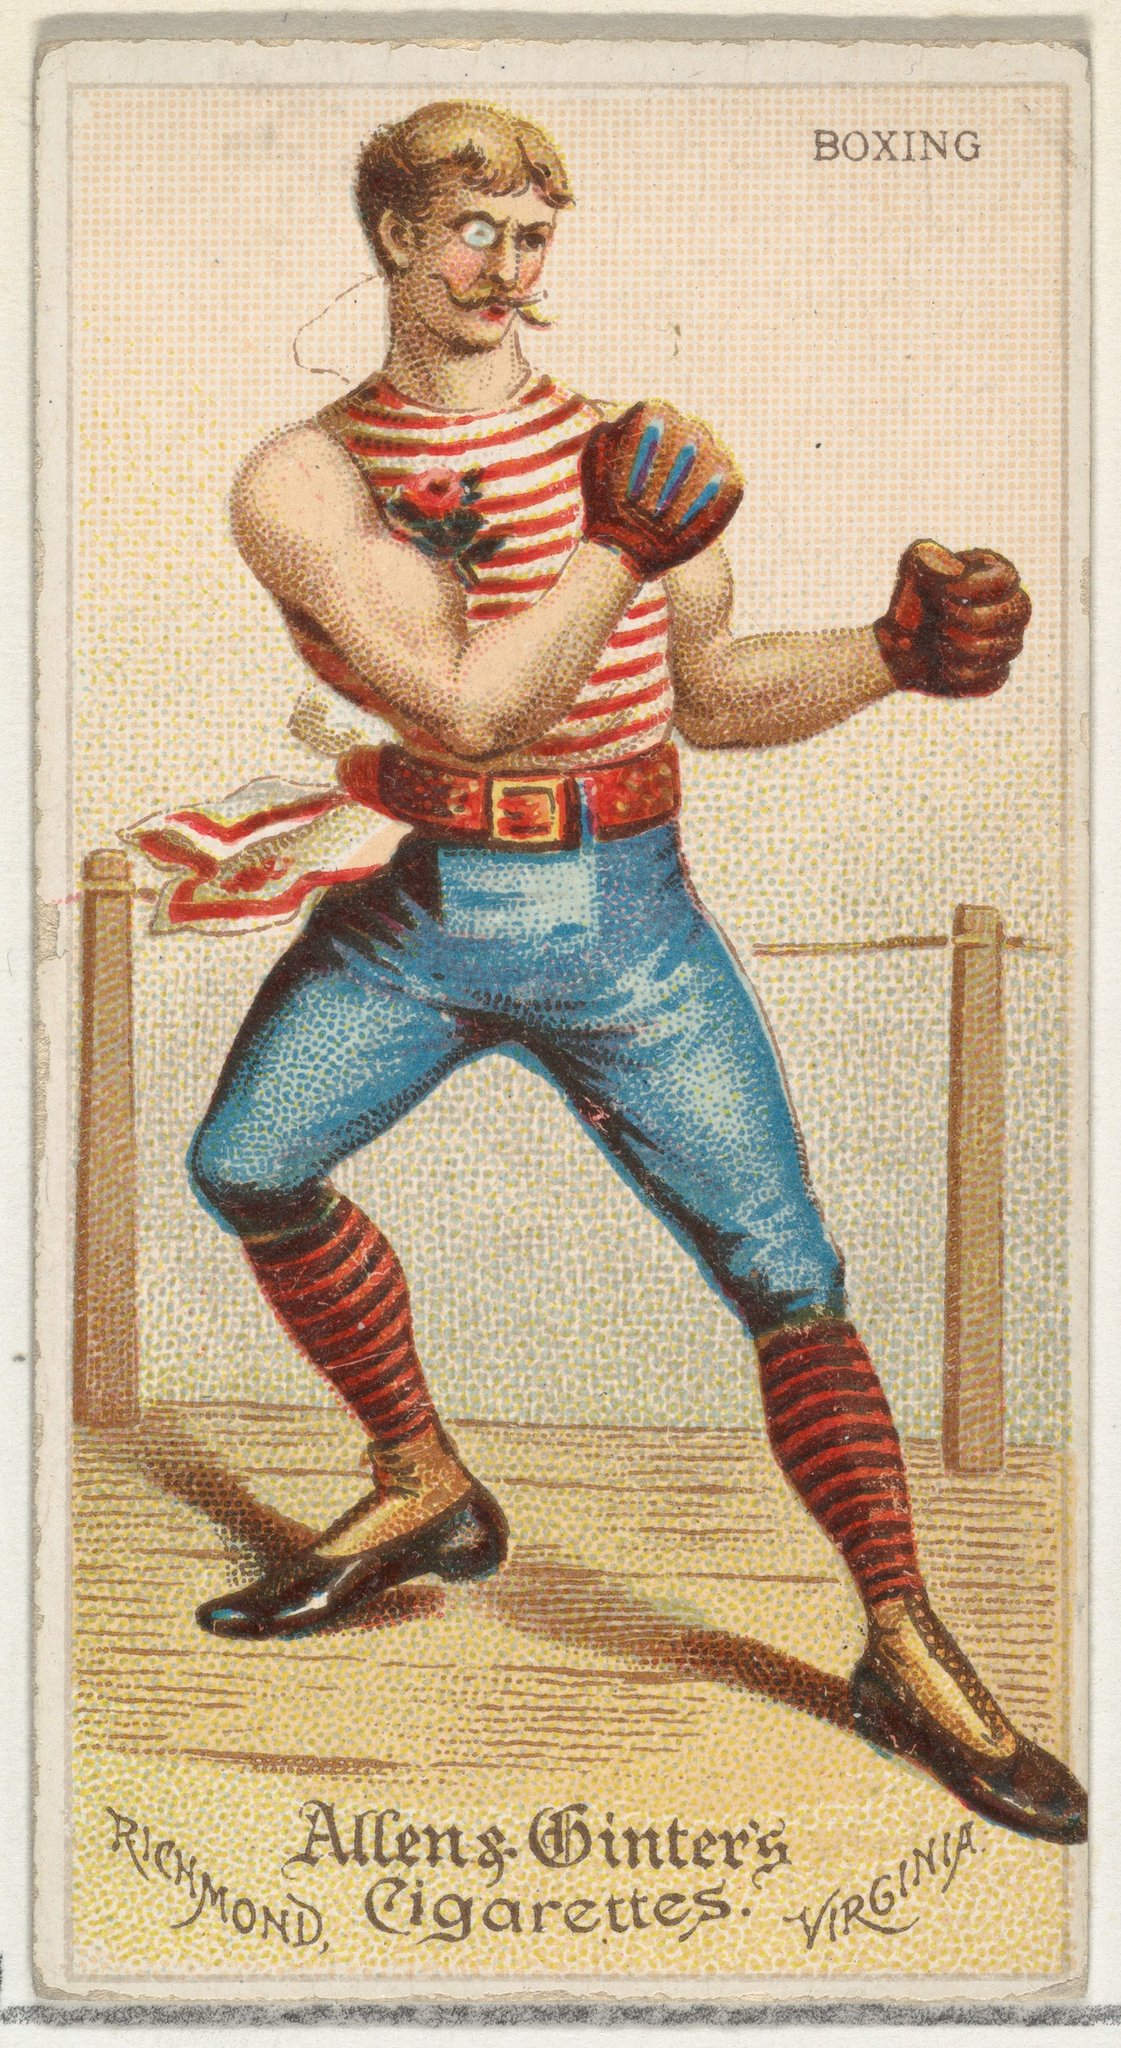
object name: print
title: Boxing, from World's Dudes series (N31) for Allen & Ginter Cigarettes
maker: allen & ginter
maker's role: publisher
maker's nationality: american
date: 1888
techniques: color lithograph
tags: men,boxing